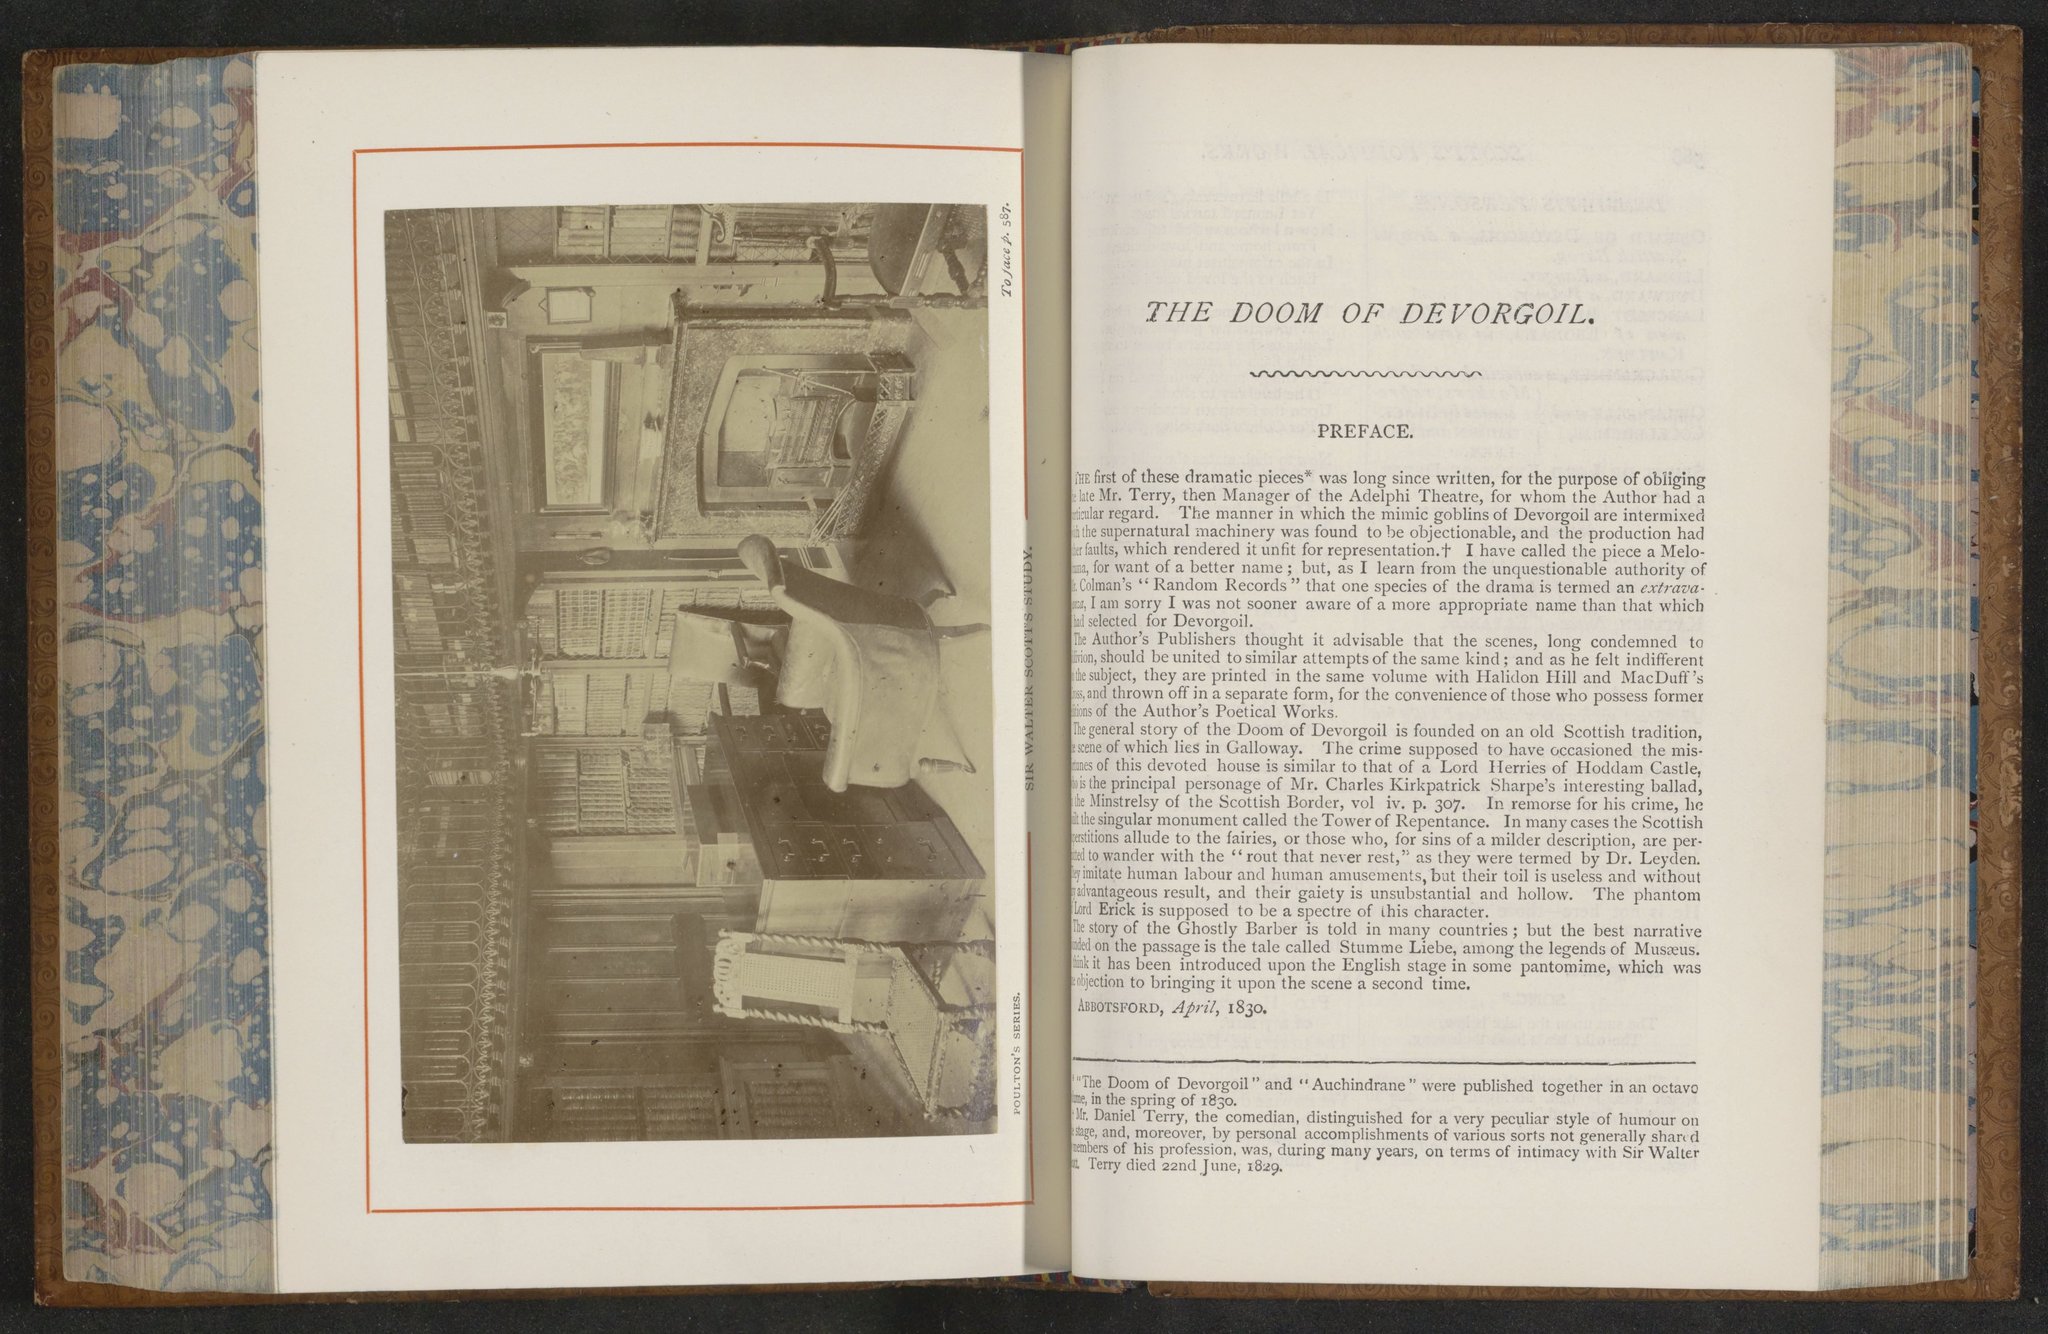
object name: photograph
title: Sir Walter Scotts Study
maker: Anonymous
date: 1880-1890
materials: photographic support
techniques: albumen print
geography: abbotsford house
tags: study; 'studiolo'; library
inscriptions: inscription: ‘Poulton's series.’